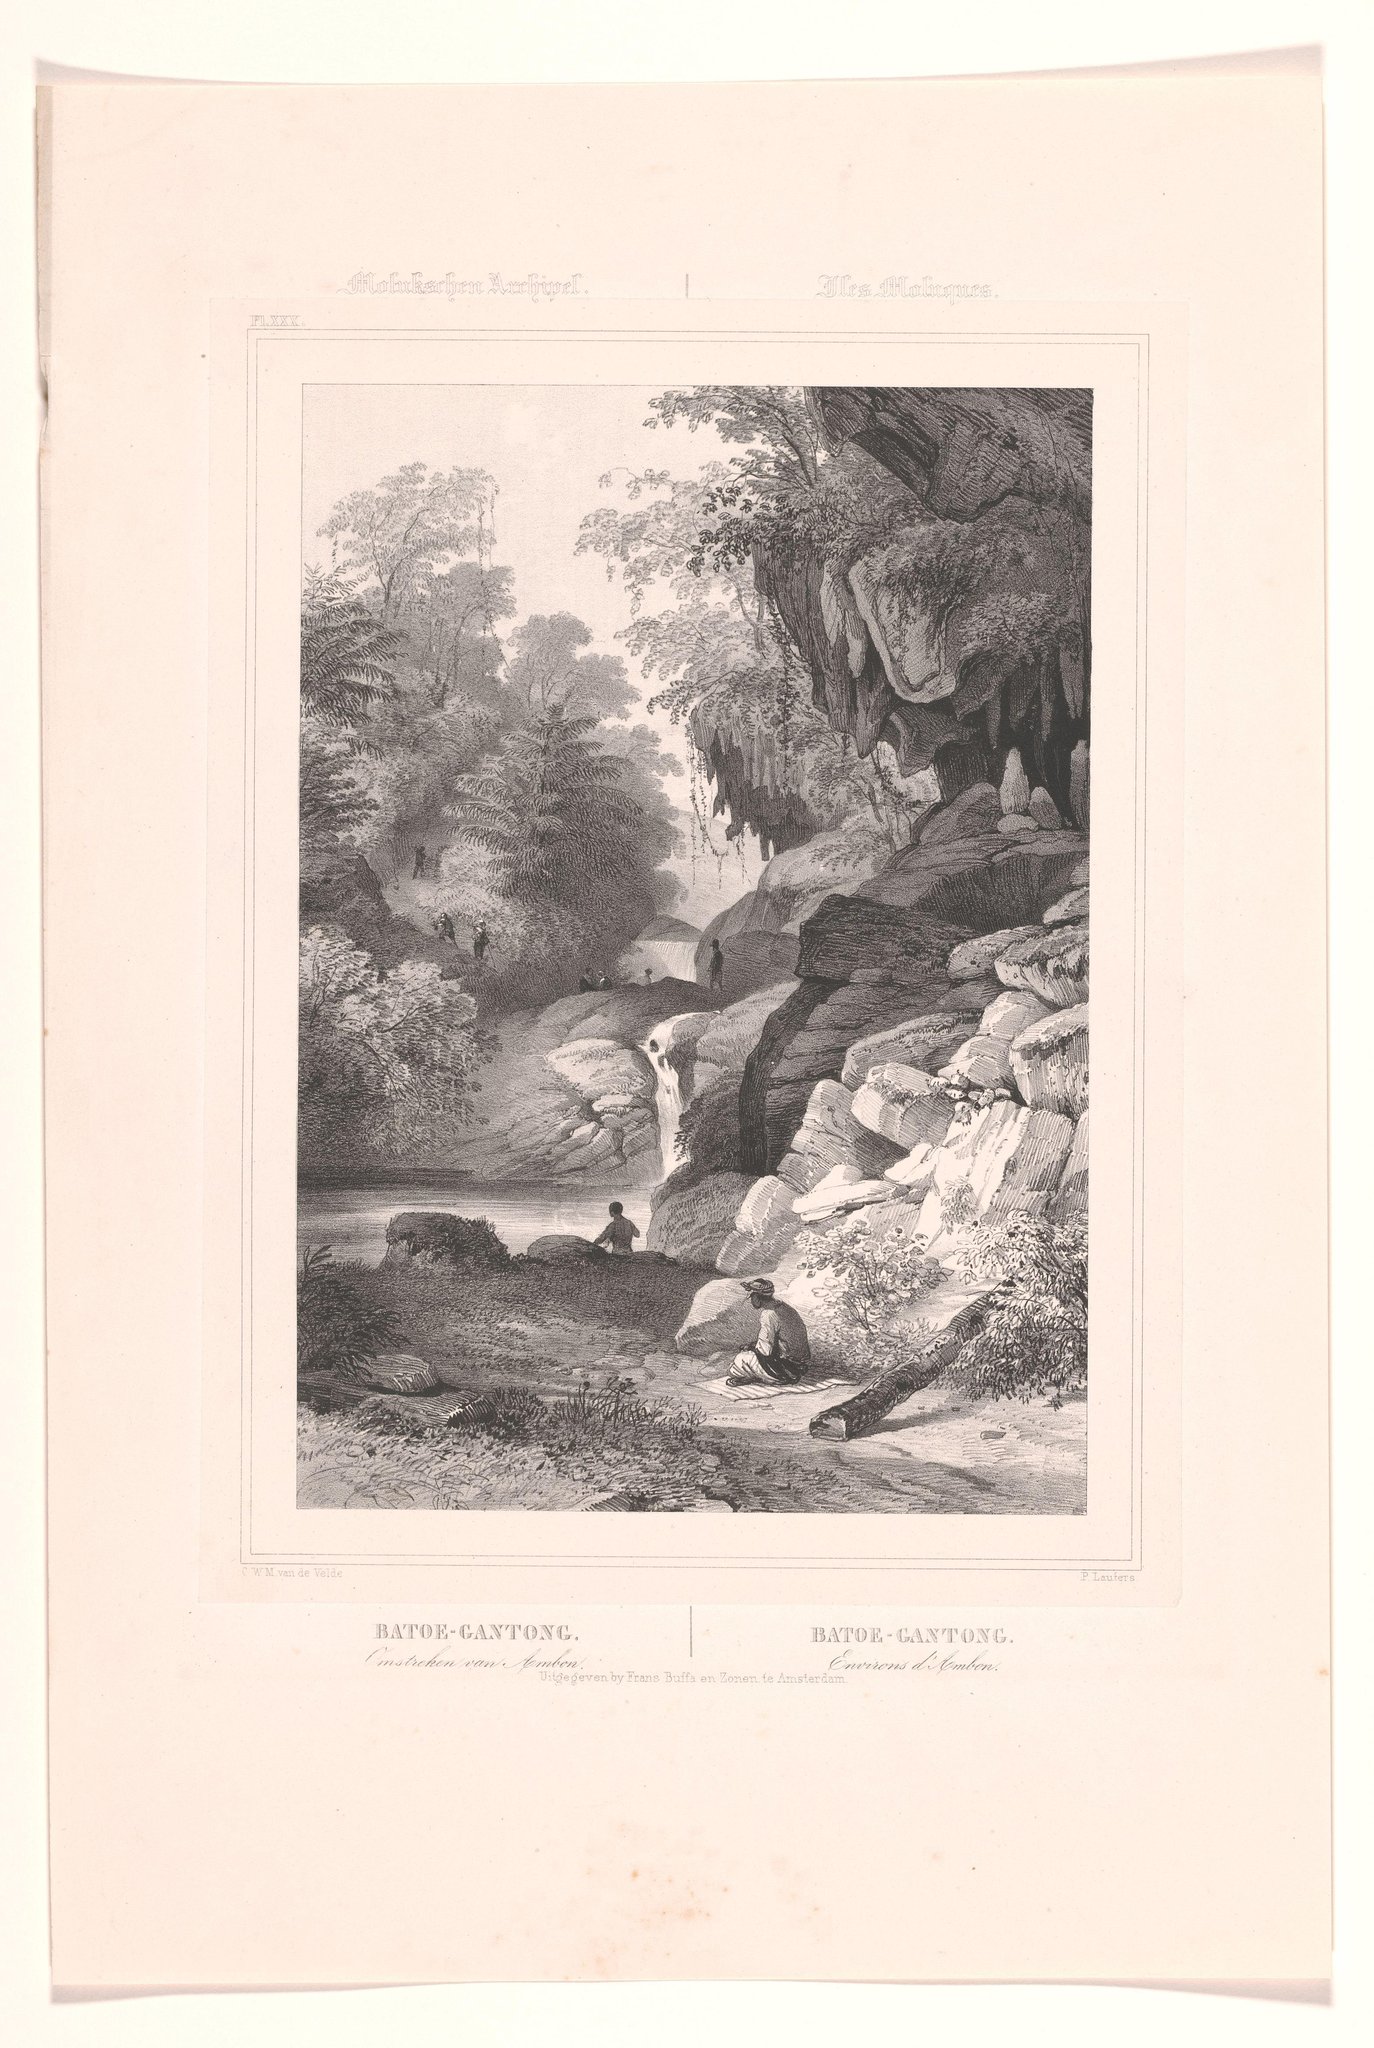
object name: print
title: Molukschen Archipel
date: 1843-1845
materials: paper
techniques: lithograph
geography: amsterdam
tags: rock-formations, waterfall (+ landscape with figures, staffage)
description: In de voorgrond zit een man op een kleed. Een andere man wast zich in de rivier. Tussen de rotsen lopen en klimmen figuren. Genummerd linksboven: Pl. XXX. De prent maakt deel uit van een omslag met elf bladen.